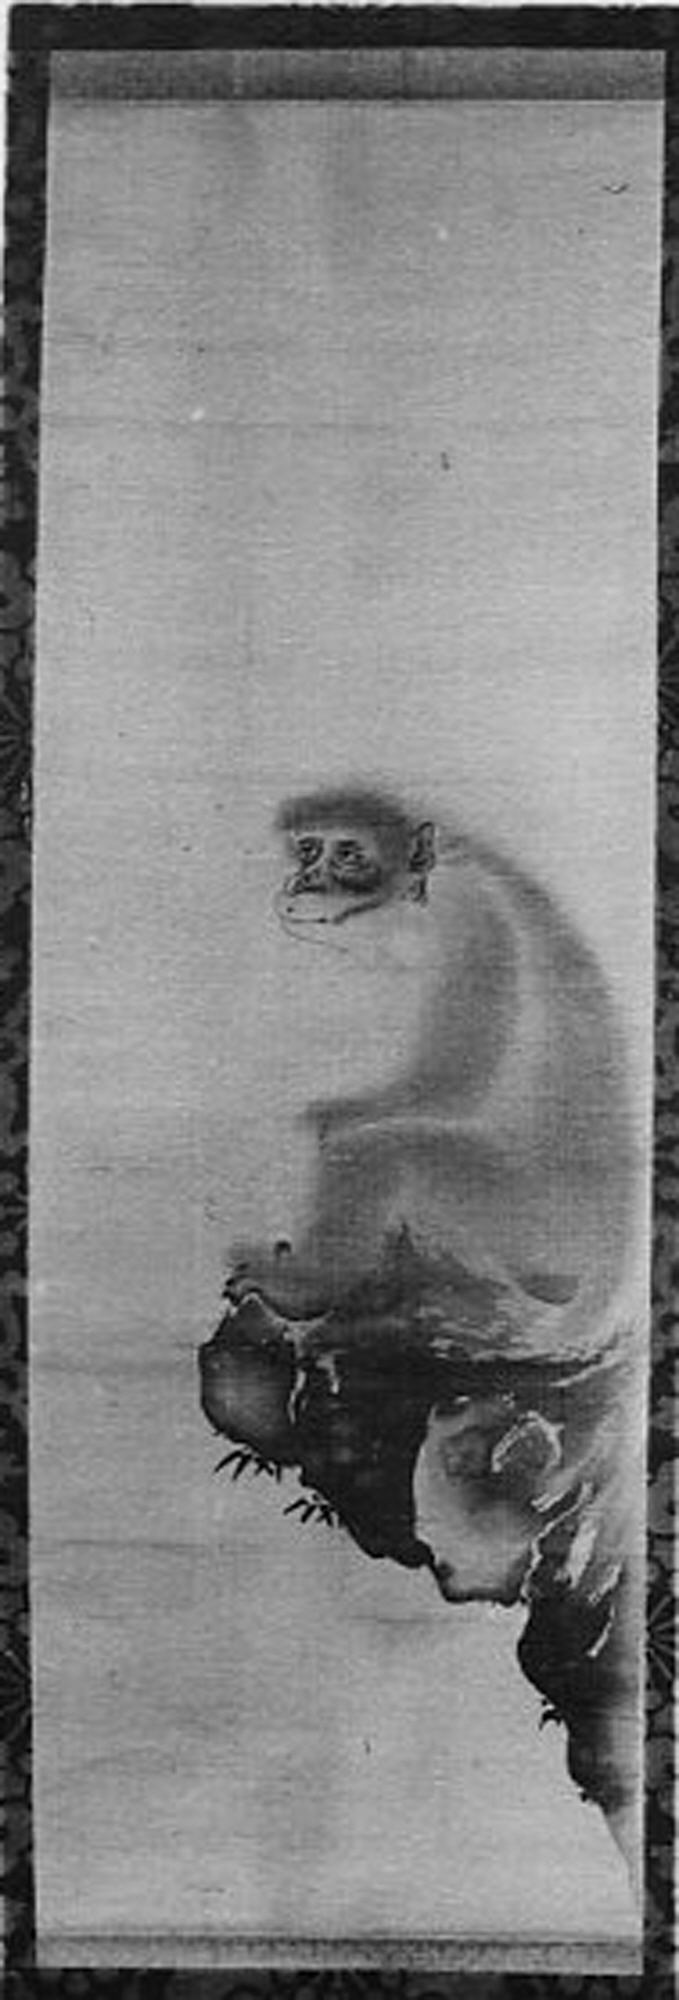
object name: hanging scroll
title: Monkey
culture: japanese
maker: mori sosen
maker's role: artist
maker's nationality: japanese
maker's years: 1747-1821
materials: ink, silk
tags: monkeys